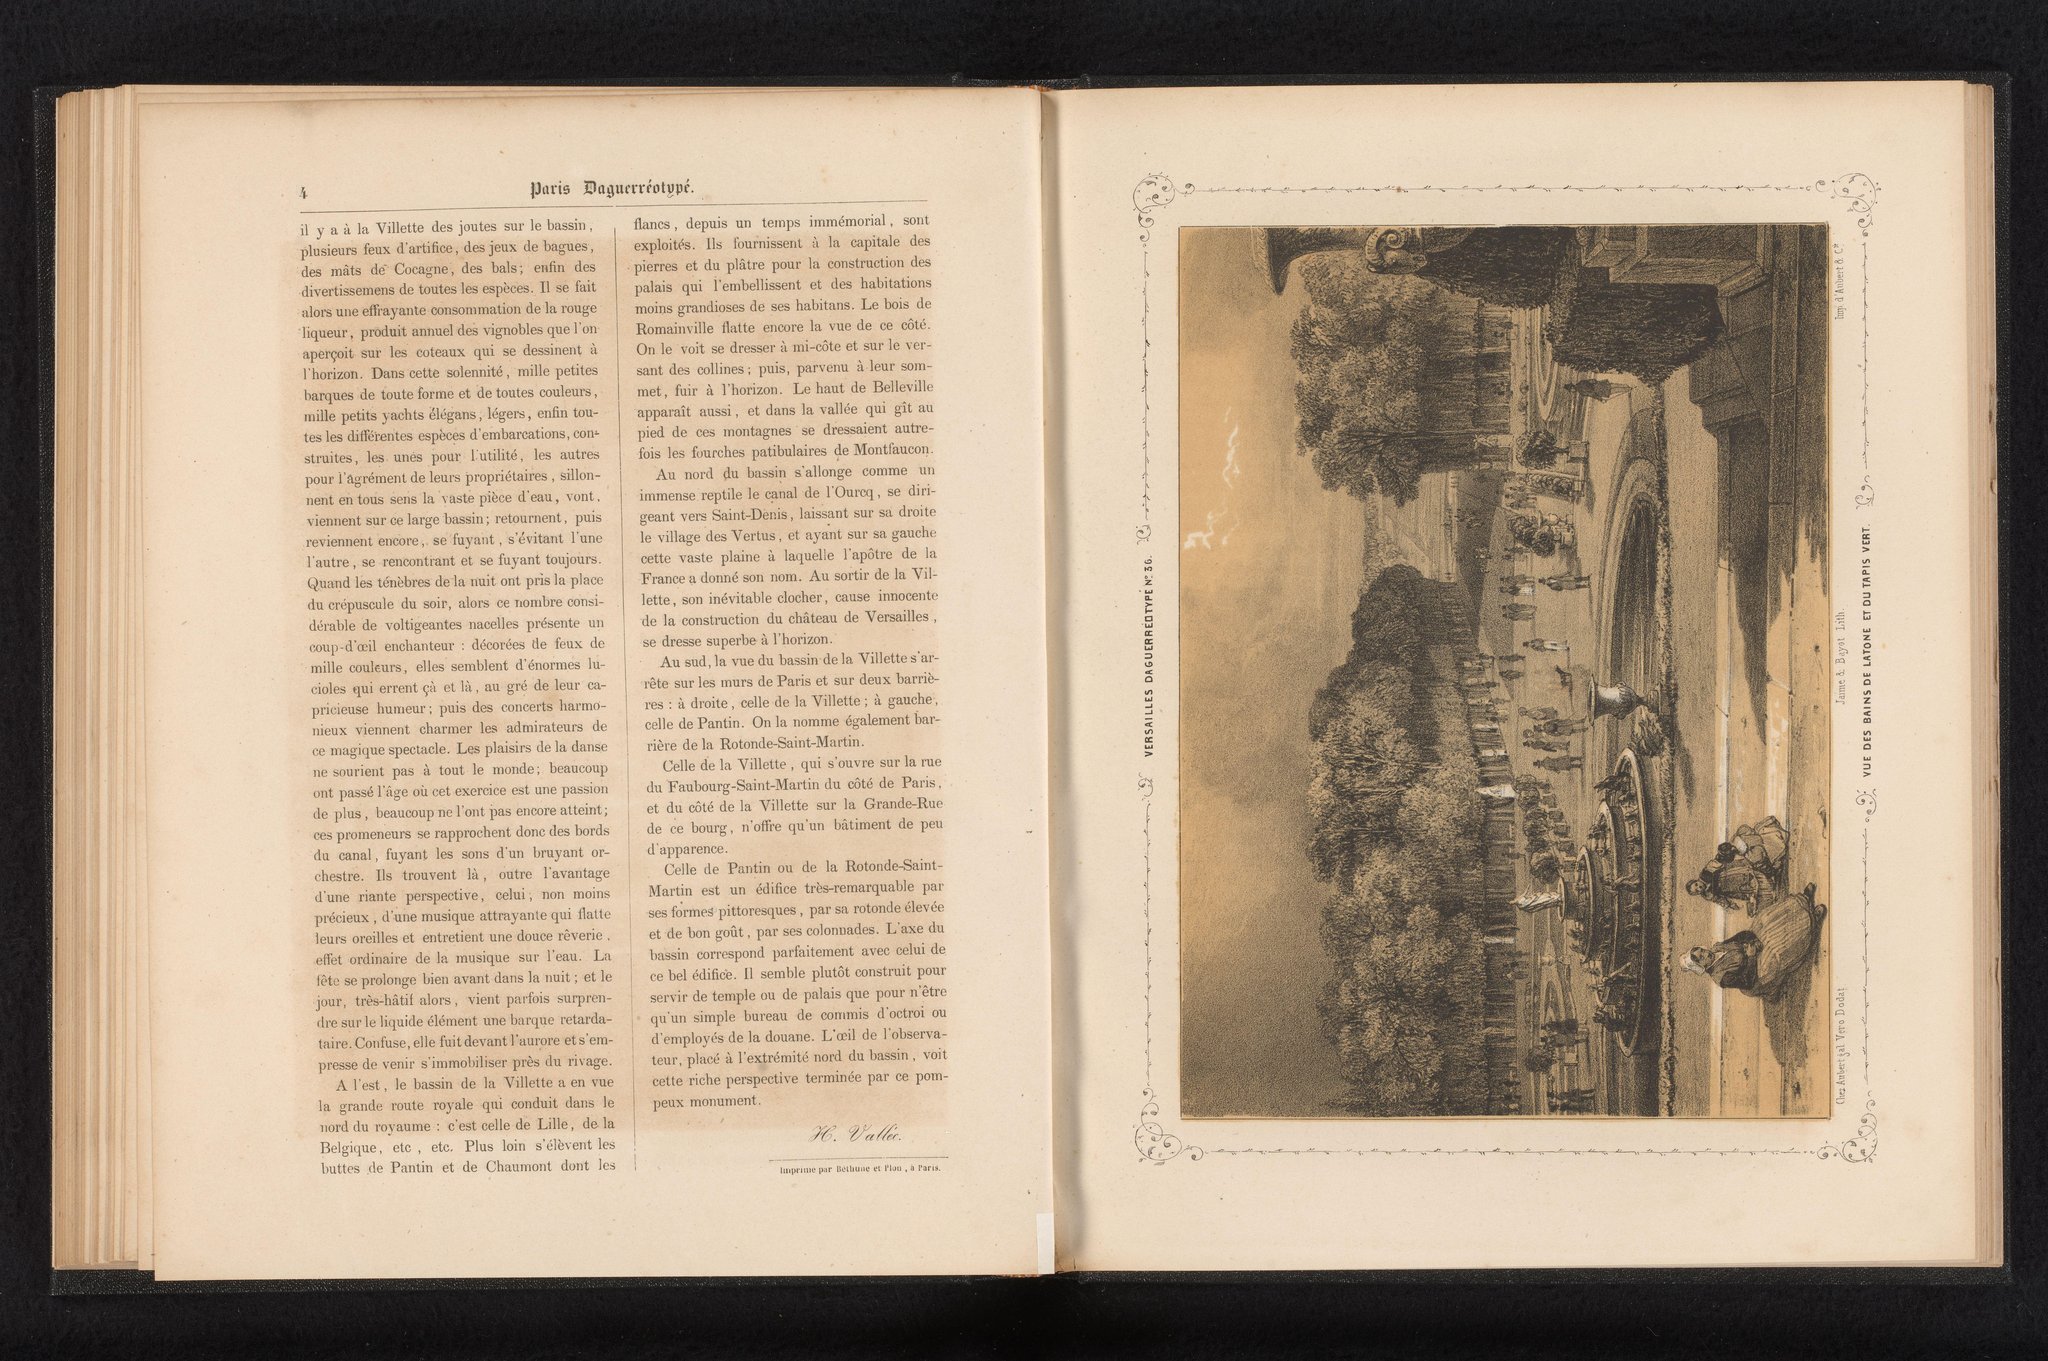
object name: page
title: Latonavijver in de tuinen van Versailles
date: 1839-1840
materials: paper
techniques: tone lithography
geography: paris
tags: ornamental fountain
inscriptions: inscription: ‘VERSAILLES DAGUERRÉOTYPÉ No. 36.’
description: Prent op honderddrieënveertigste ongenummerde pagina.